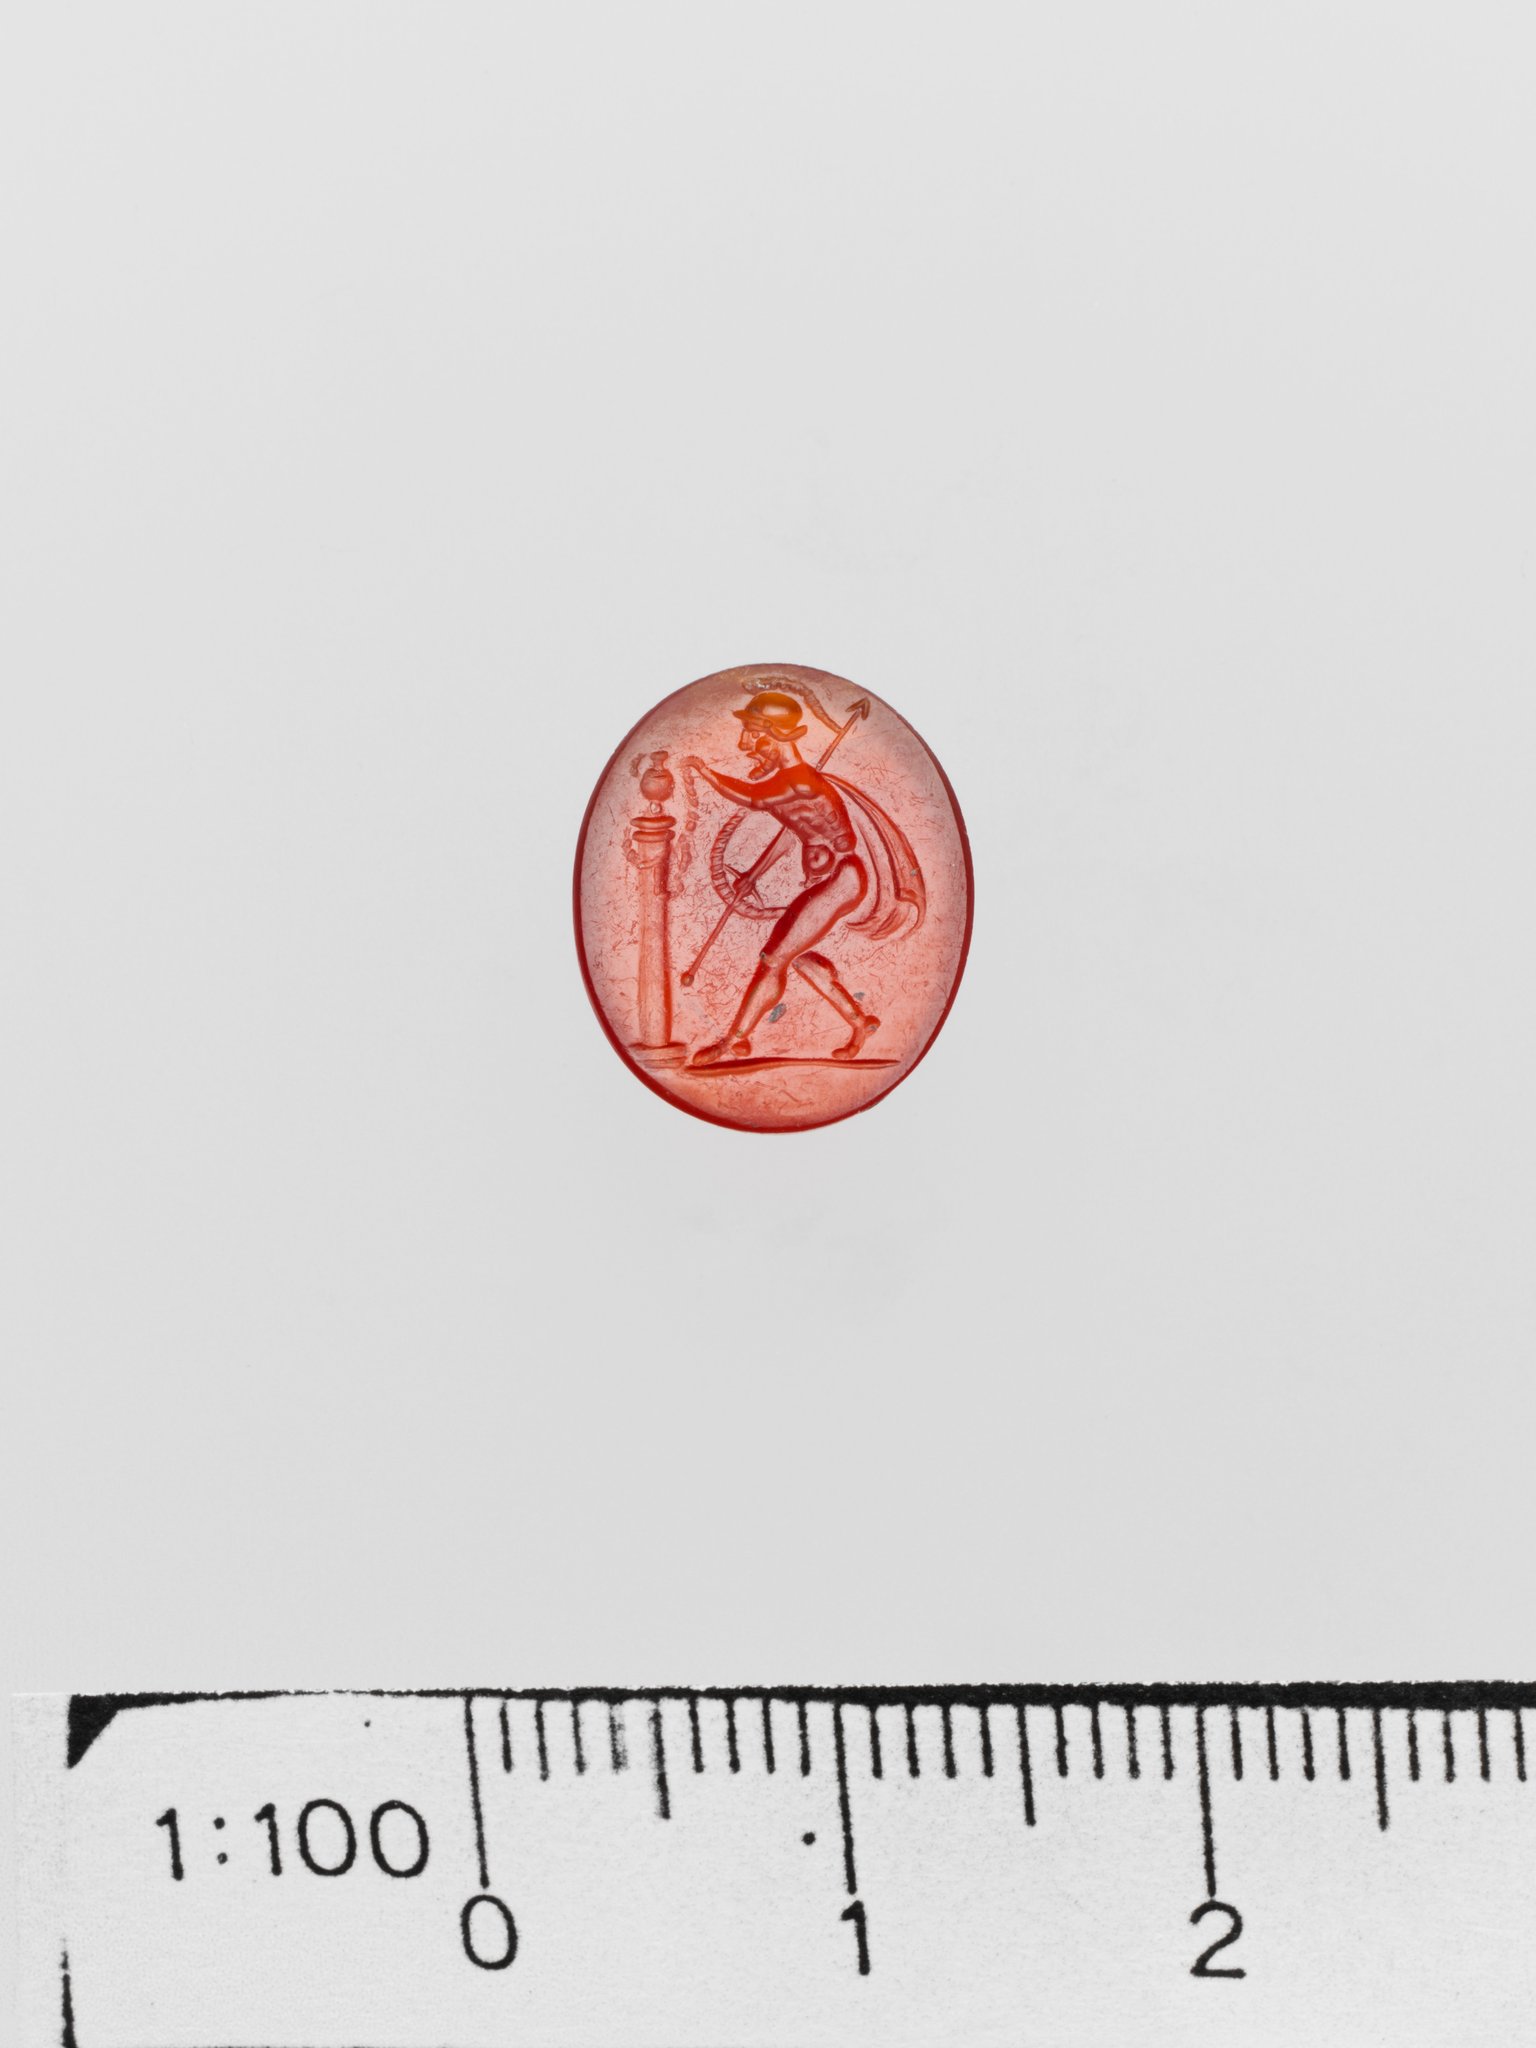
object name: intaglio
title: Carnelian ring stone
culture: italic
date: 300-101 BCE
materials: gemstone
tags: spears,men,warriors